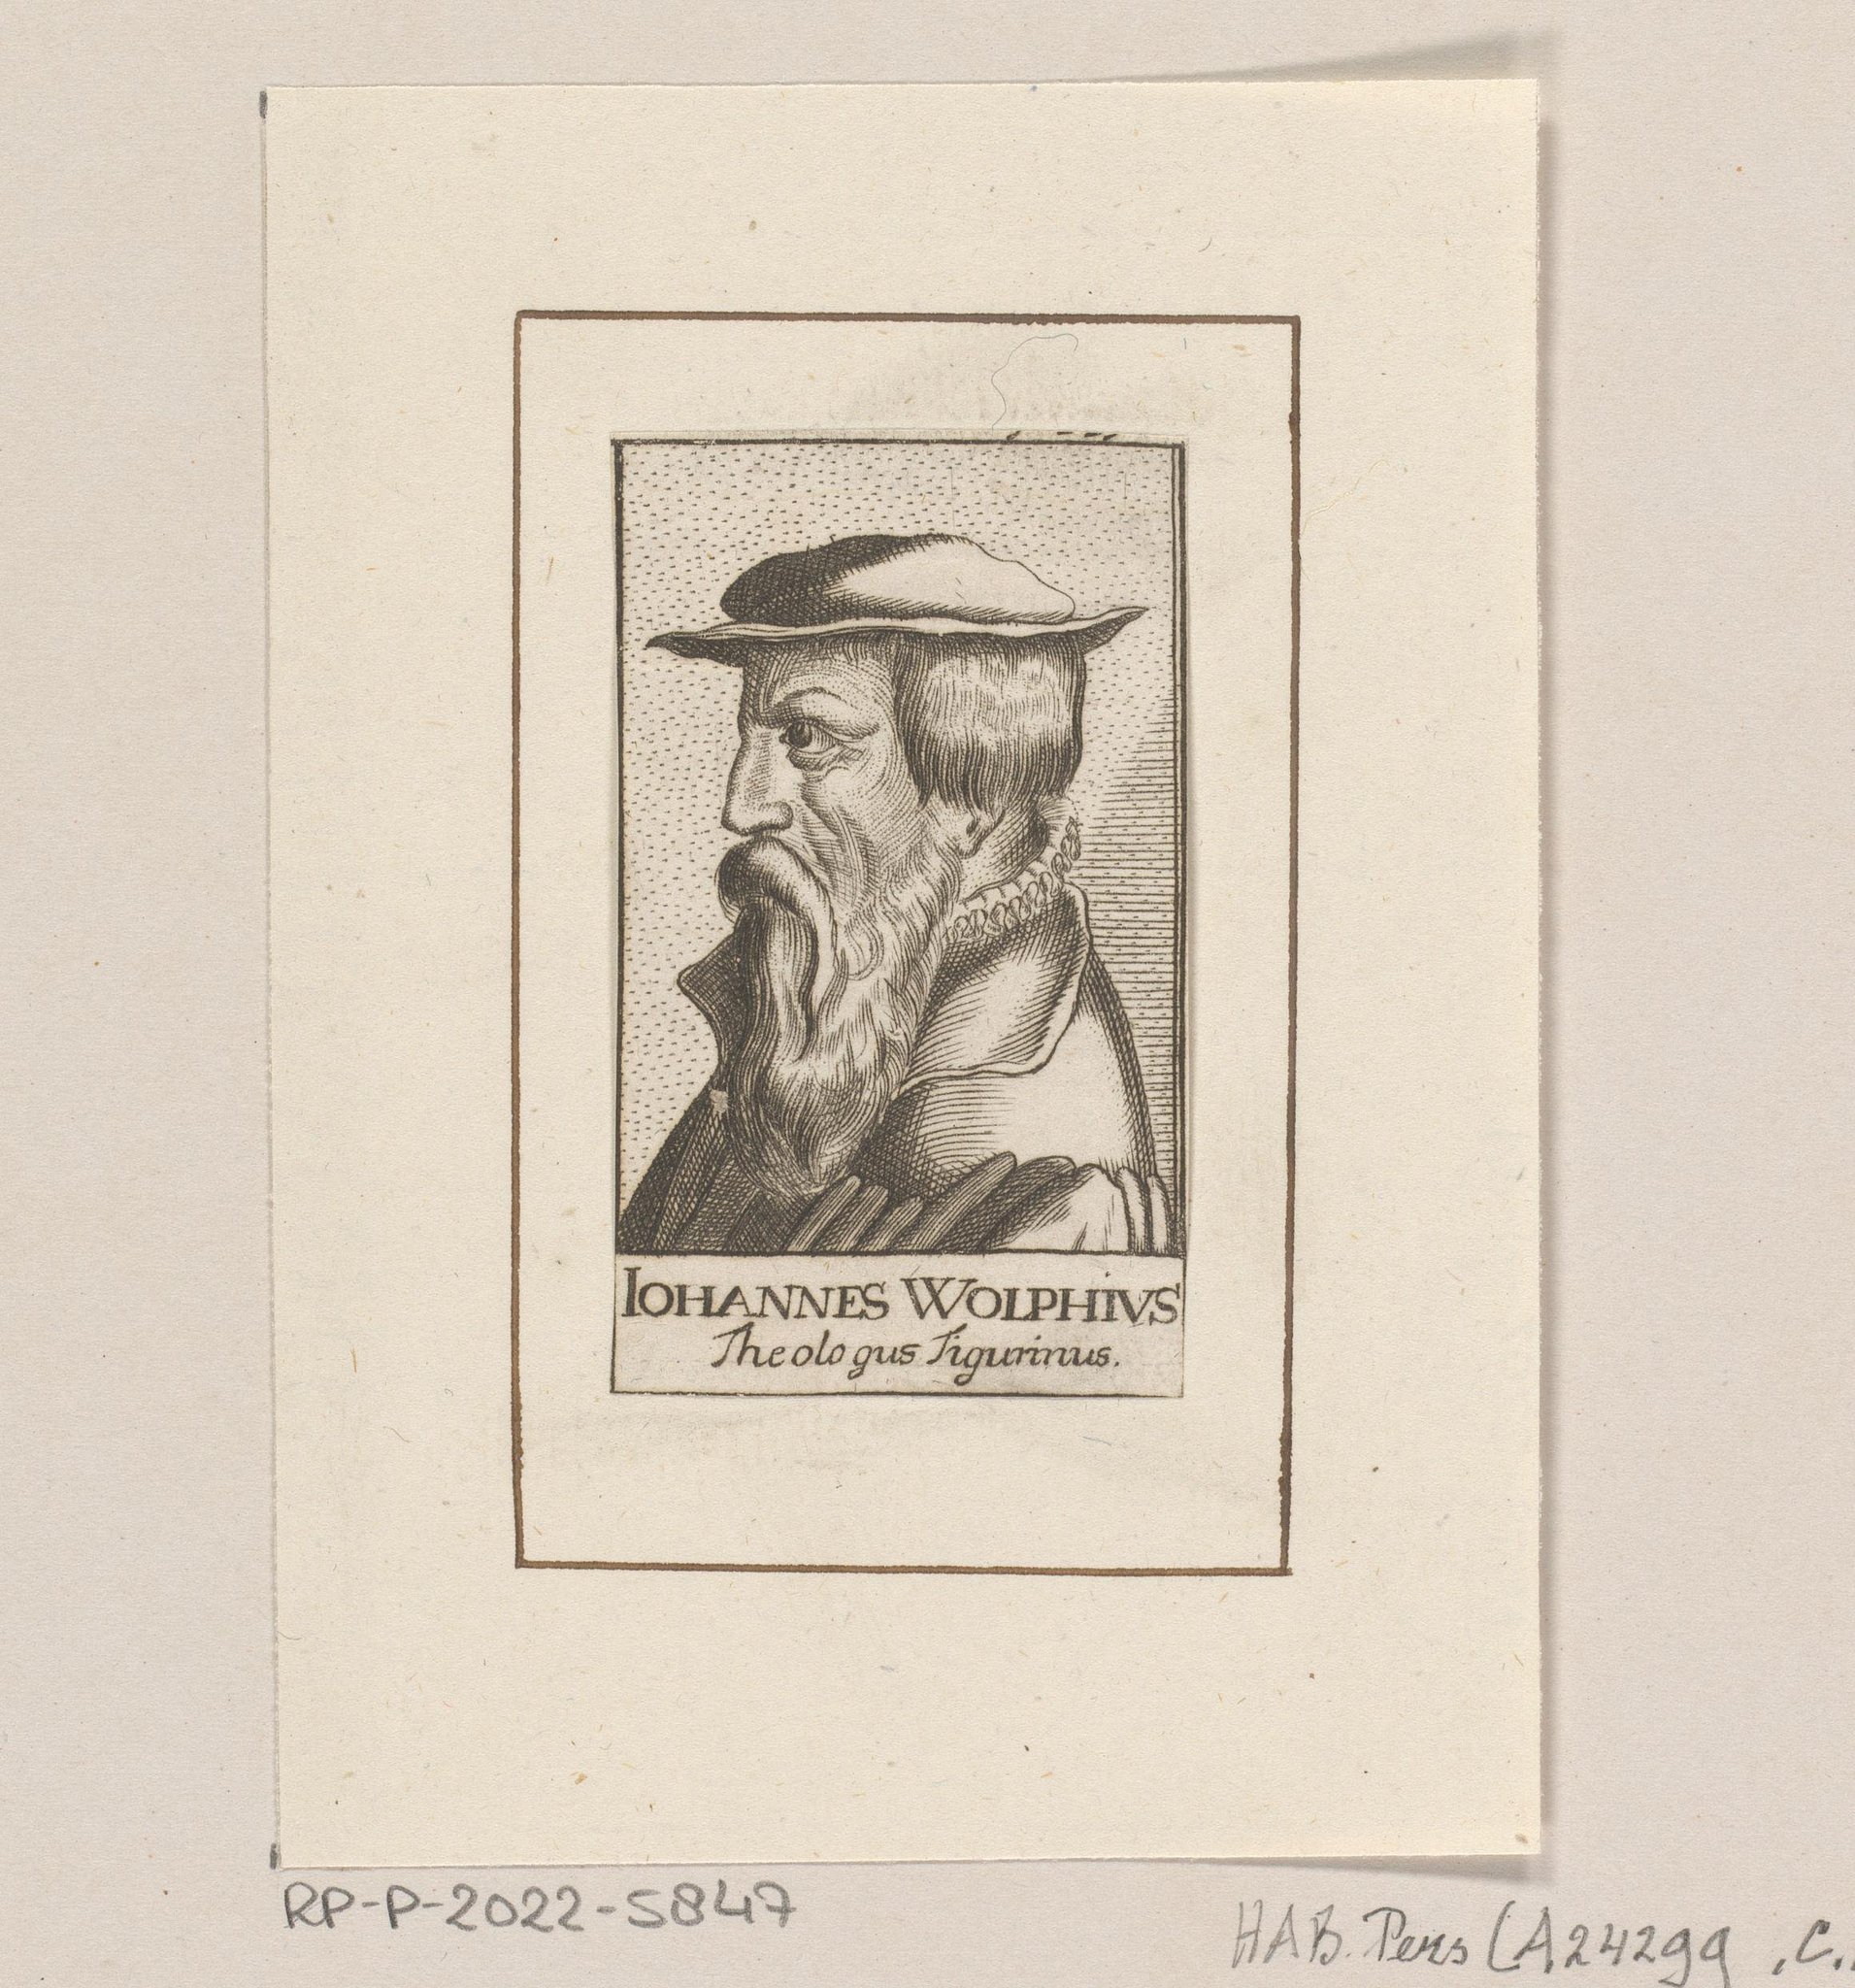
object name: book illustration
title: Portret van Johannes Wolf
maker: Anonymous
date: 1688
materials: paper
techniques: etching, snipping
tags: theologian, historical persons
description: Prent uit: Freher, Paul. Theatrum virorum eruditione clarorum. Neurenberg: Johann Hoffmann, 1688.